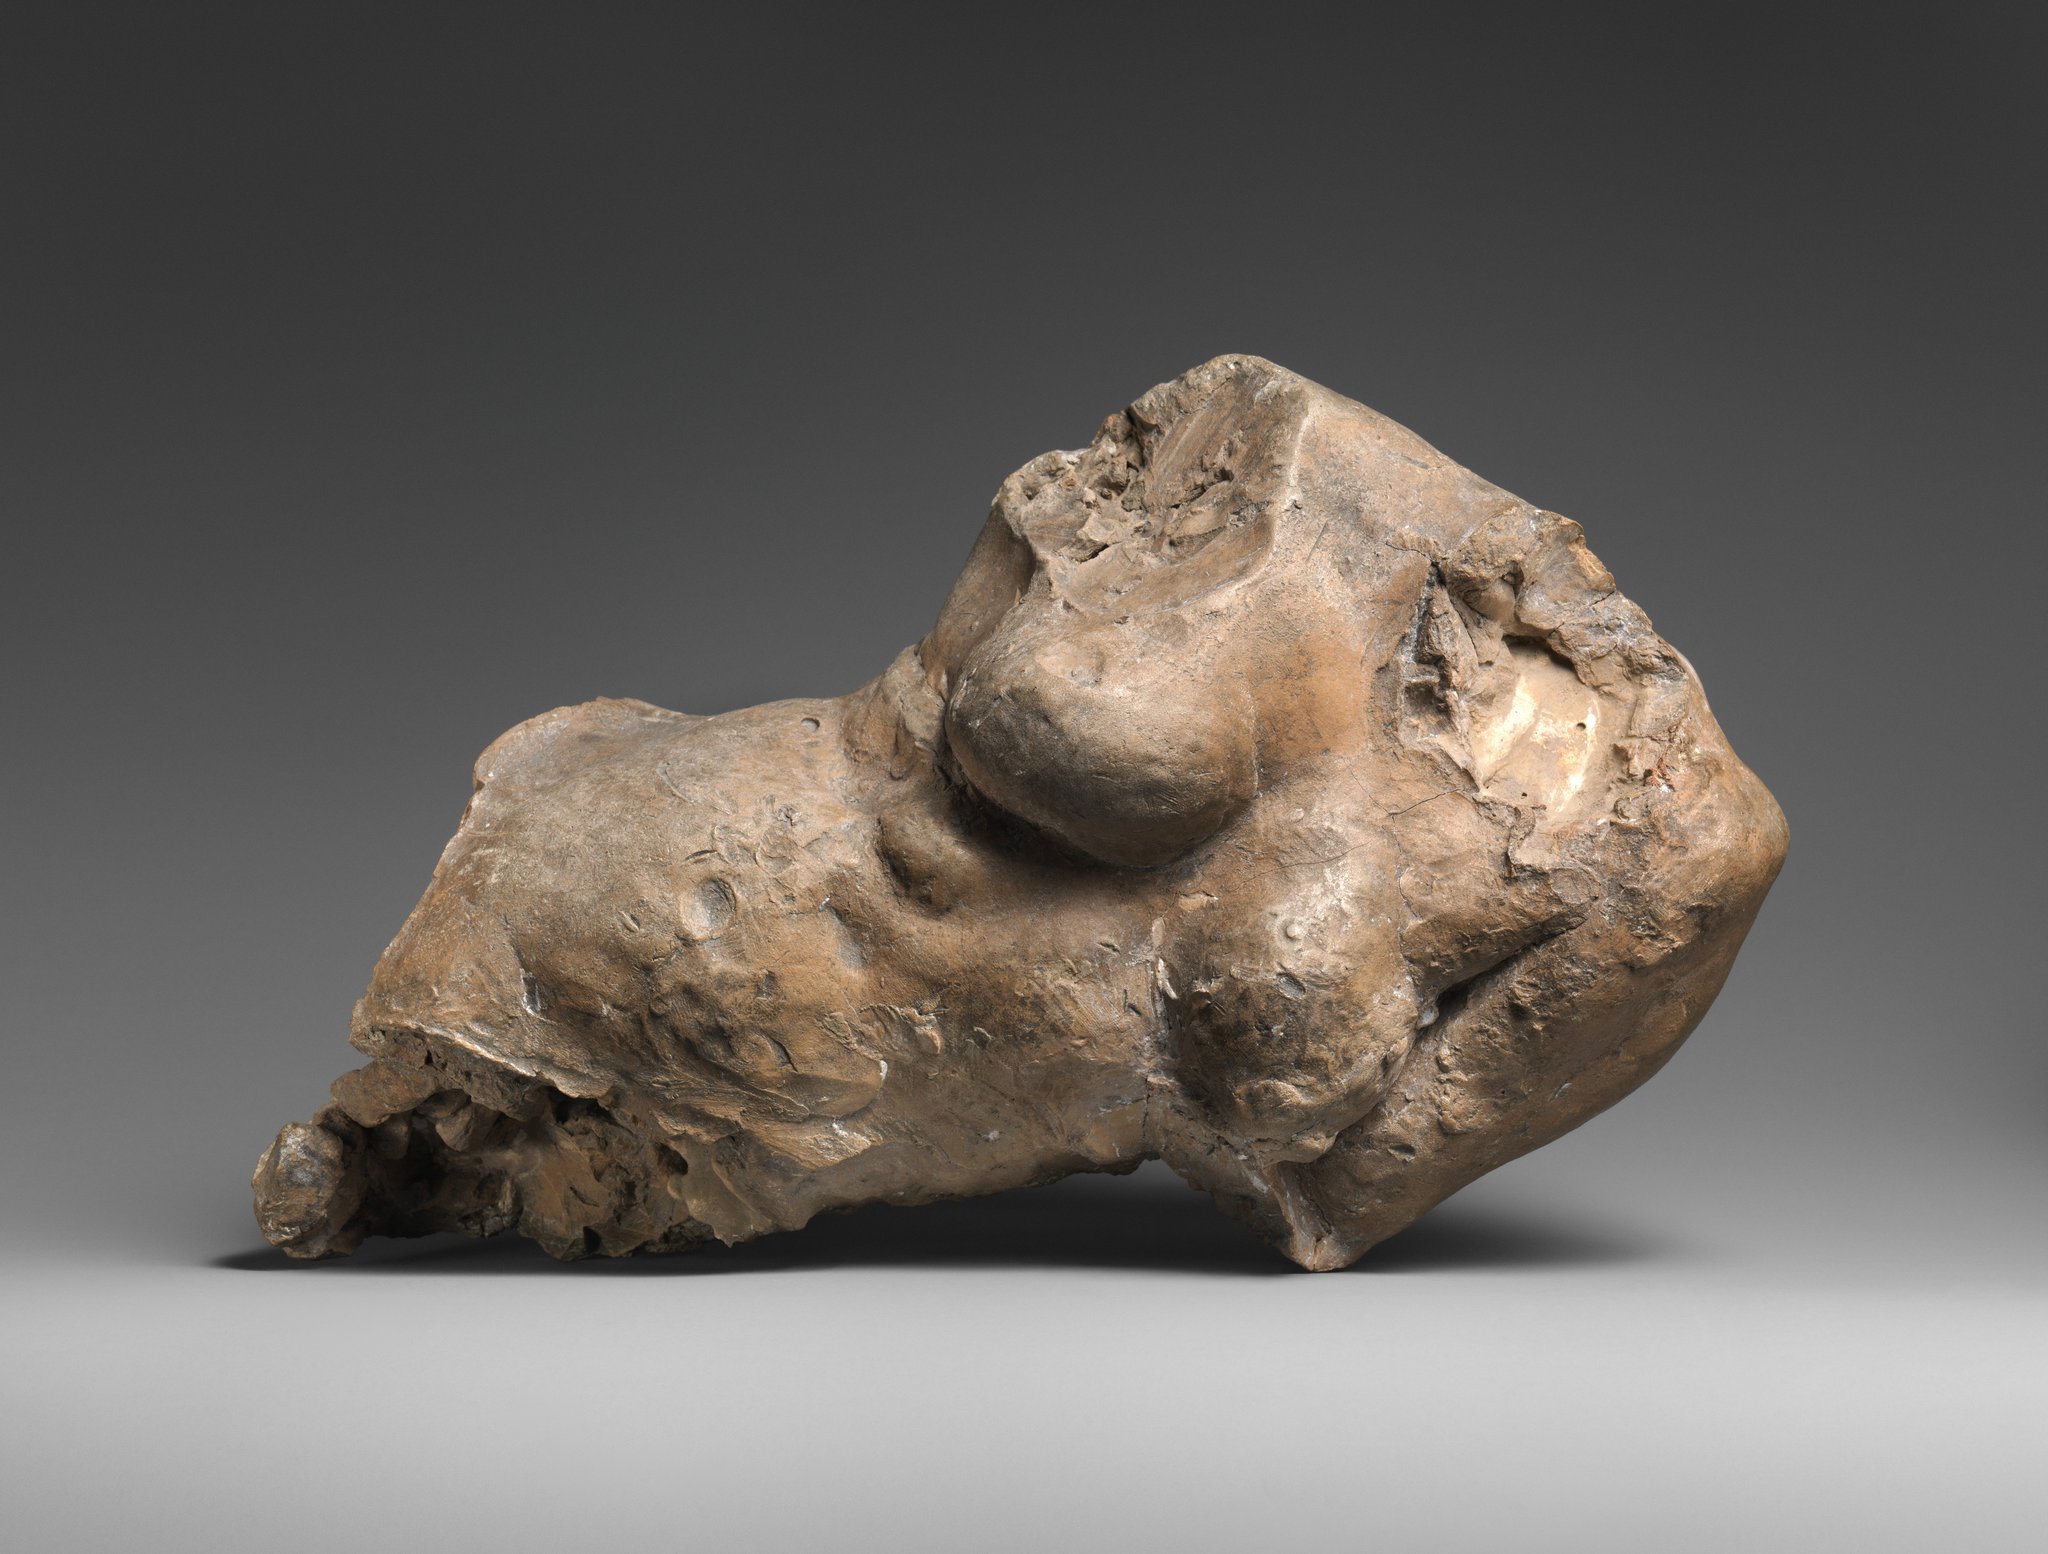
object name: torso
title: Torso (A Study for Ariane without Arms)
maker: auguste rodin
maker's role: artist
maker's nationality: french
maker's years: 1840-1917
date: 1900-1905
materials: terracotta